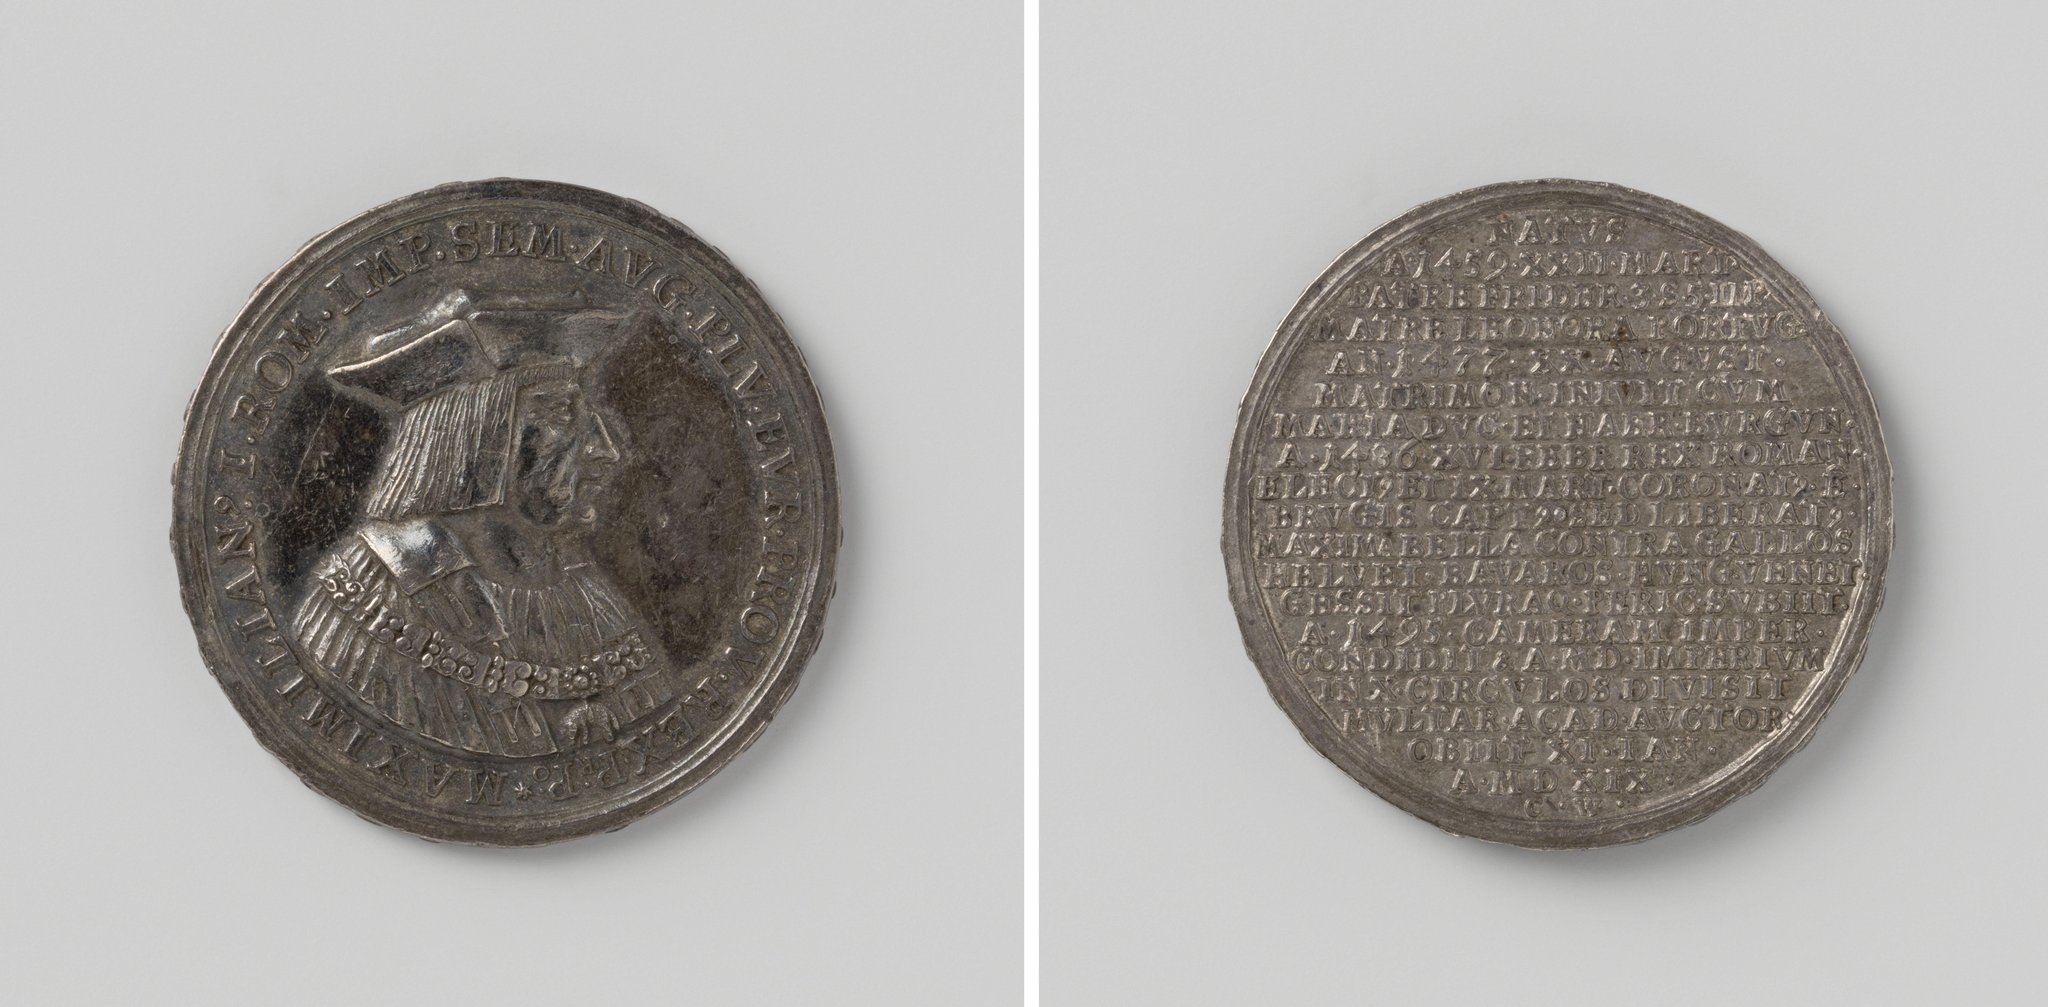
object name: jeton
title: Maximiliaan I, Duits keizer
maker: christian wermuth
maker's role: medailleur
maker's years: 1661-1739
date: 1688-1739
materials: silver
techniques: striking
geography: nuremberg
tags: maximilian i (holy roman emperor)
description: Zilveren penning. Voorzijde: borststuk man binnen omschrift. Keerzijde: opschrift